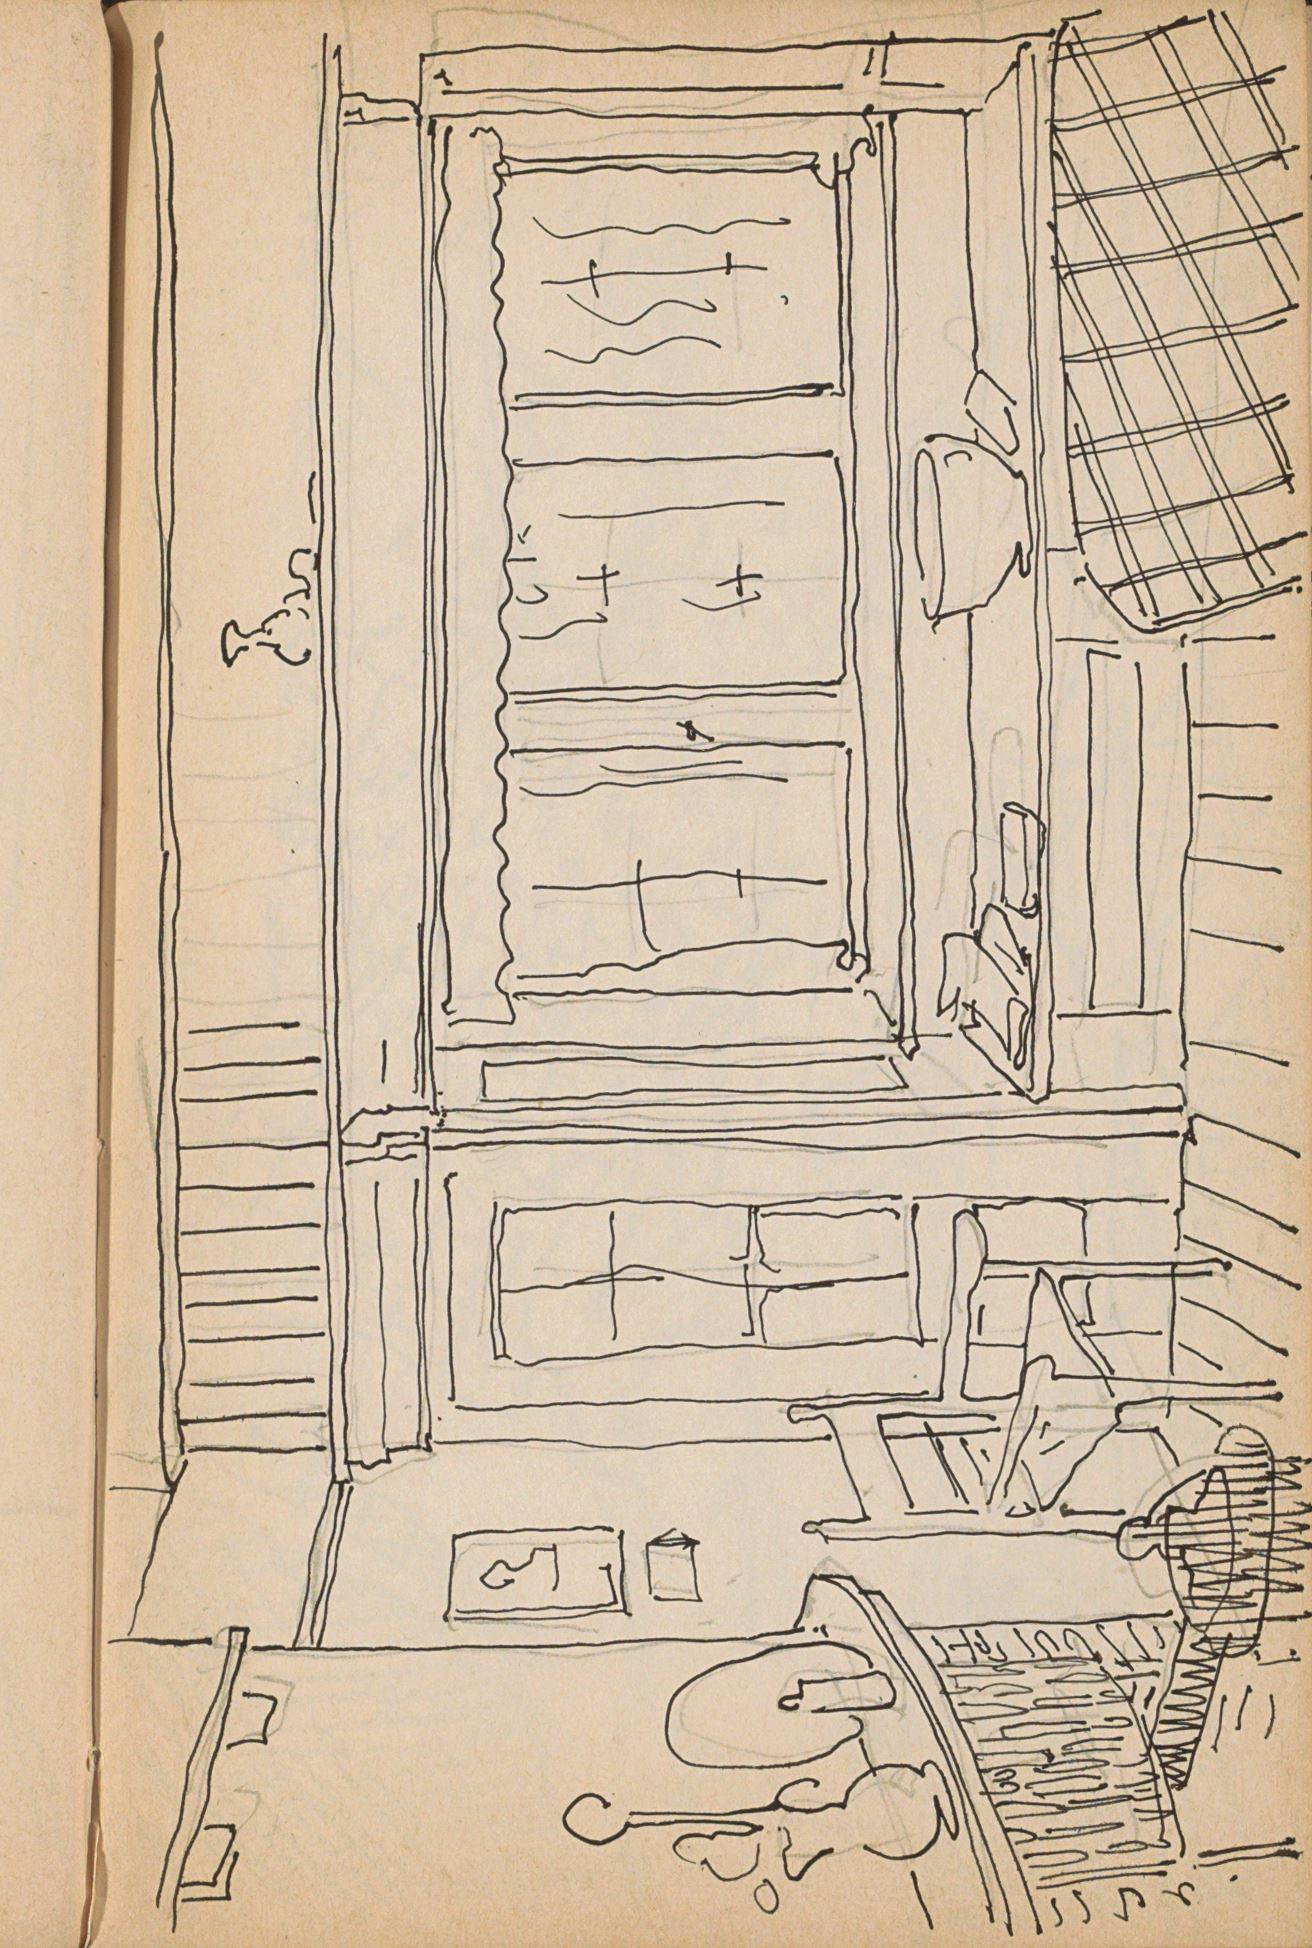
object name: sketchbook leaf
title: Interieur met een schoorsteenmantel en zithoek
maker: reijer stolk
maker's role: draughtsman, print maker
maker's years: 1896-1945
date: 1908-1919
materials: ink, paper, pencil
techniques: pen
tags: seating furniture, interior of the house, chimney-piece, mantelpiece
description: Blad 29 recto uit een schetsboek met 33 bladen.